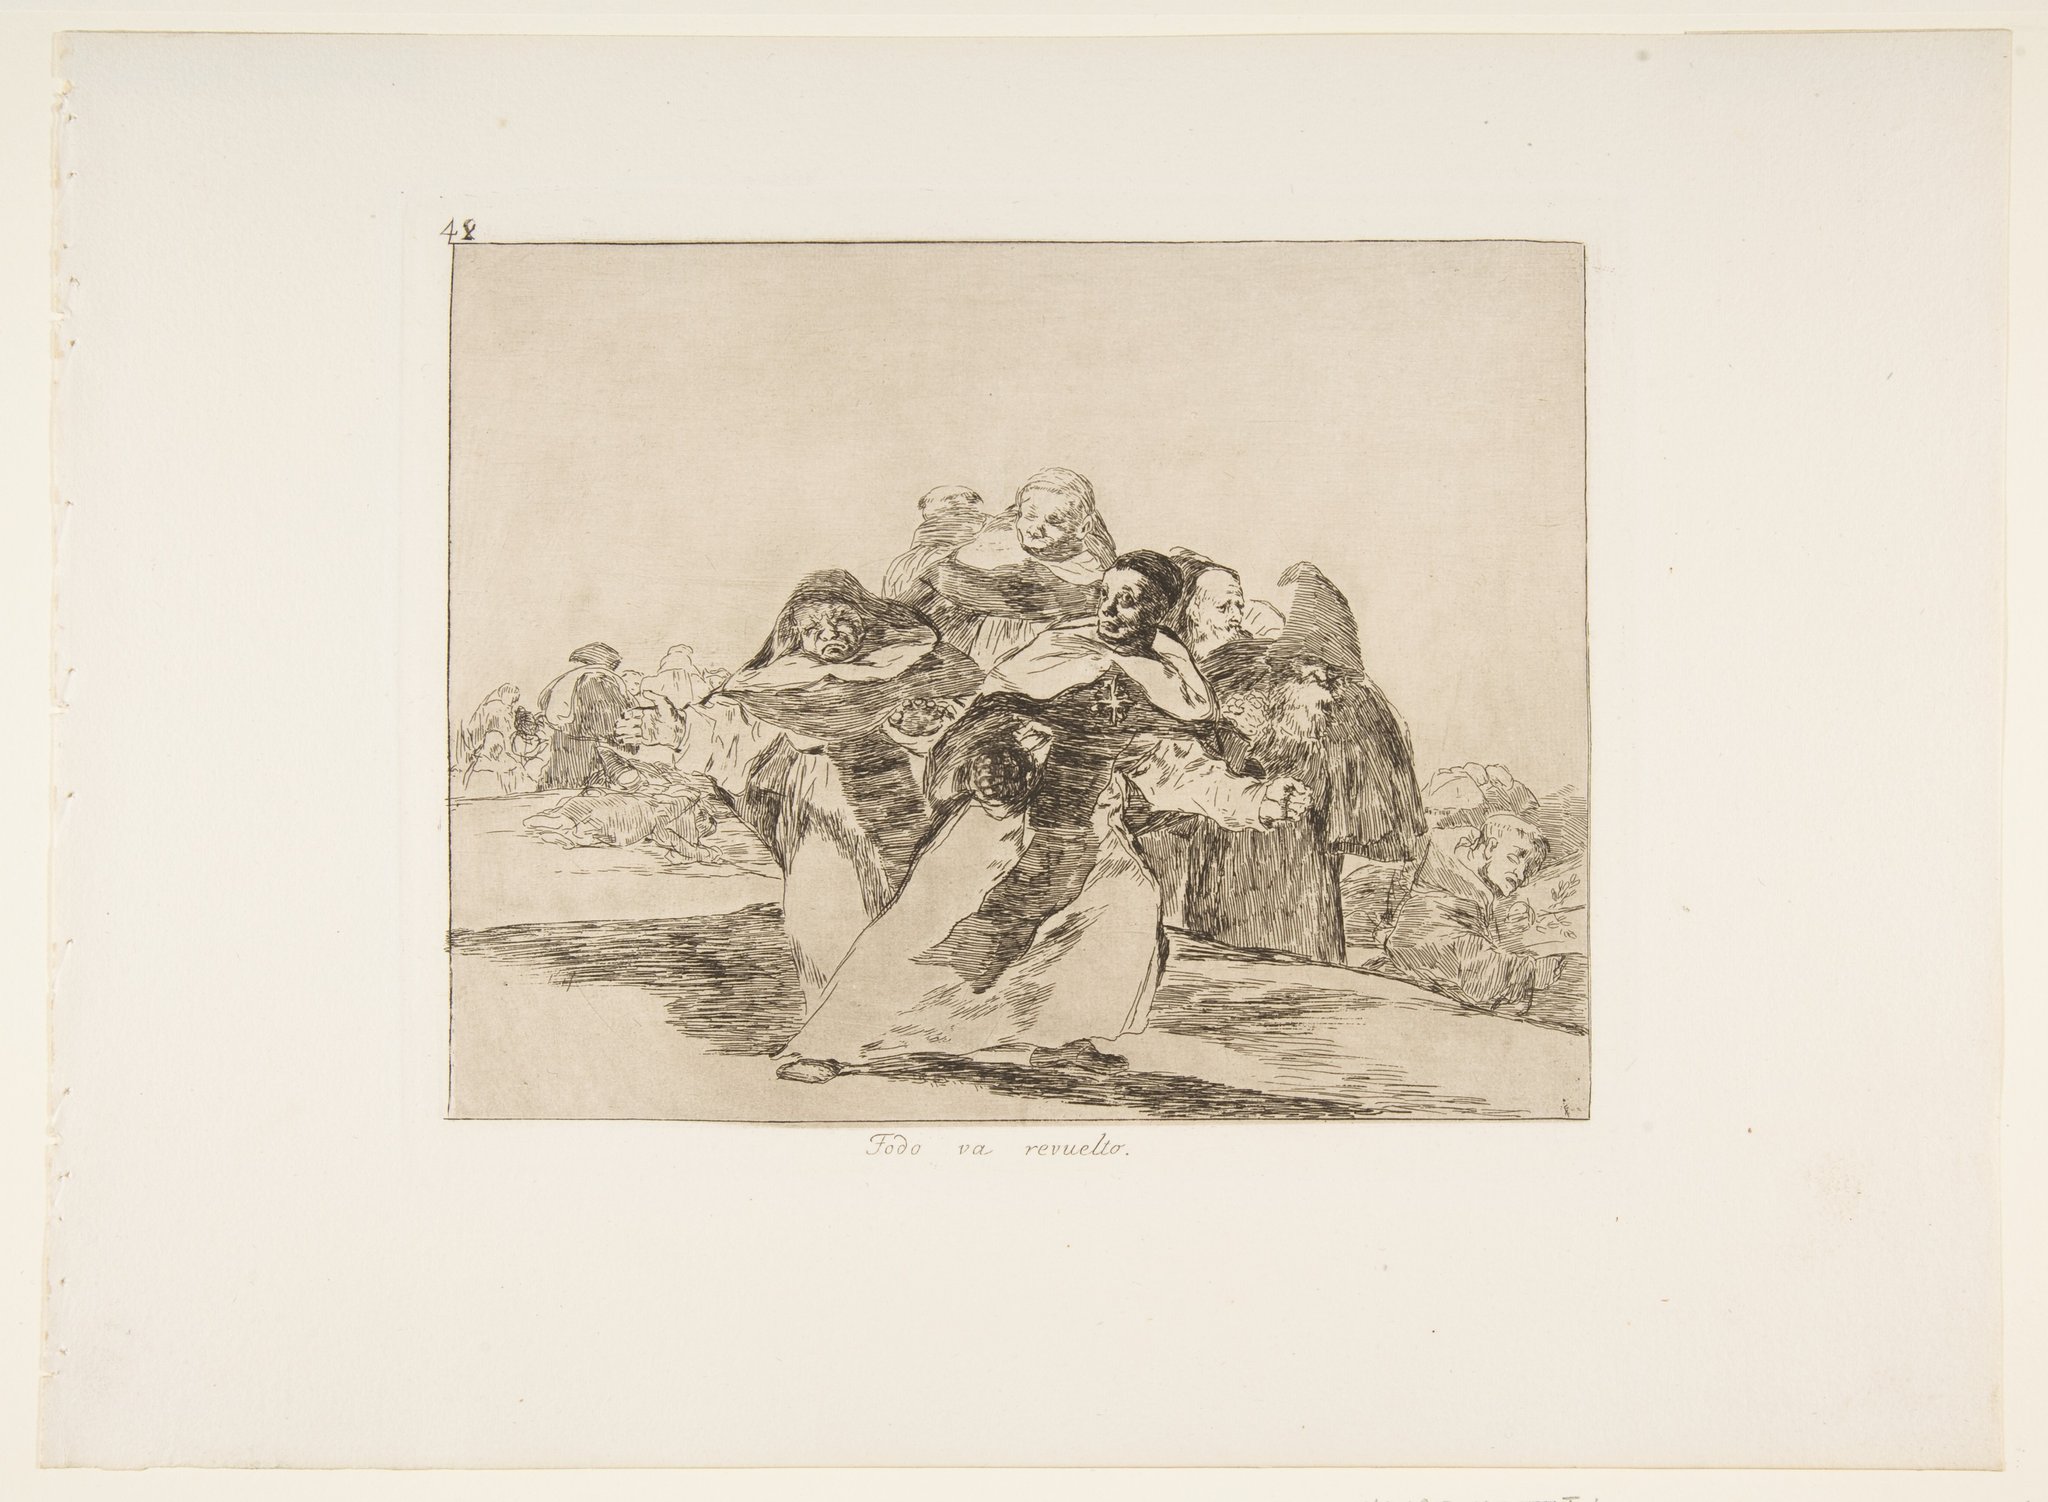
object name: print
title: Plate 42 from "The Disasters of War" (Los Desastres de la Guerra): 'Everything is topsy-turvey' (Todo va revuelto)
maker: goya (francisco de goya y lucientes)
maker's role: artist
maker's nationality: spanish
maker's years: 1746-1828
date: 1810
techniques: engraving, etching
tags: men,women